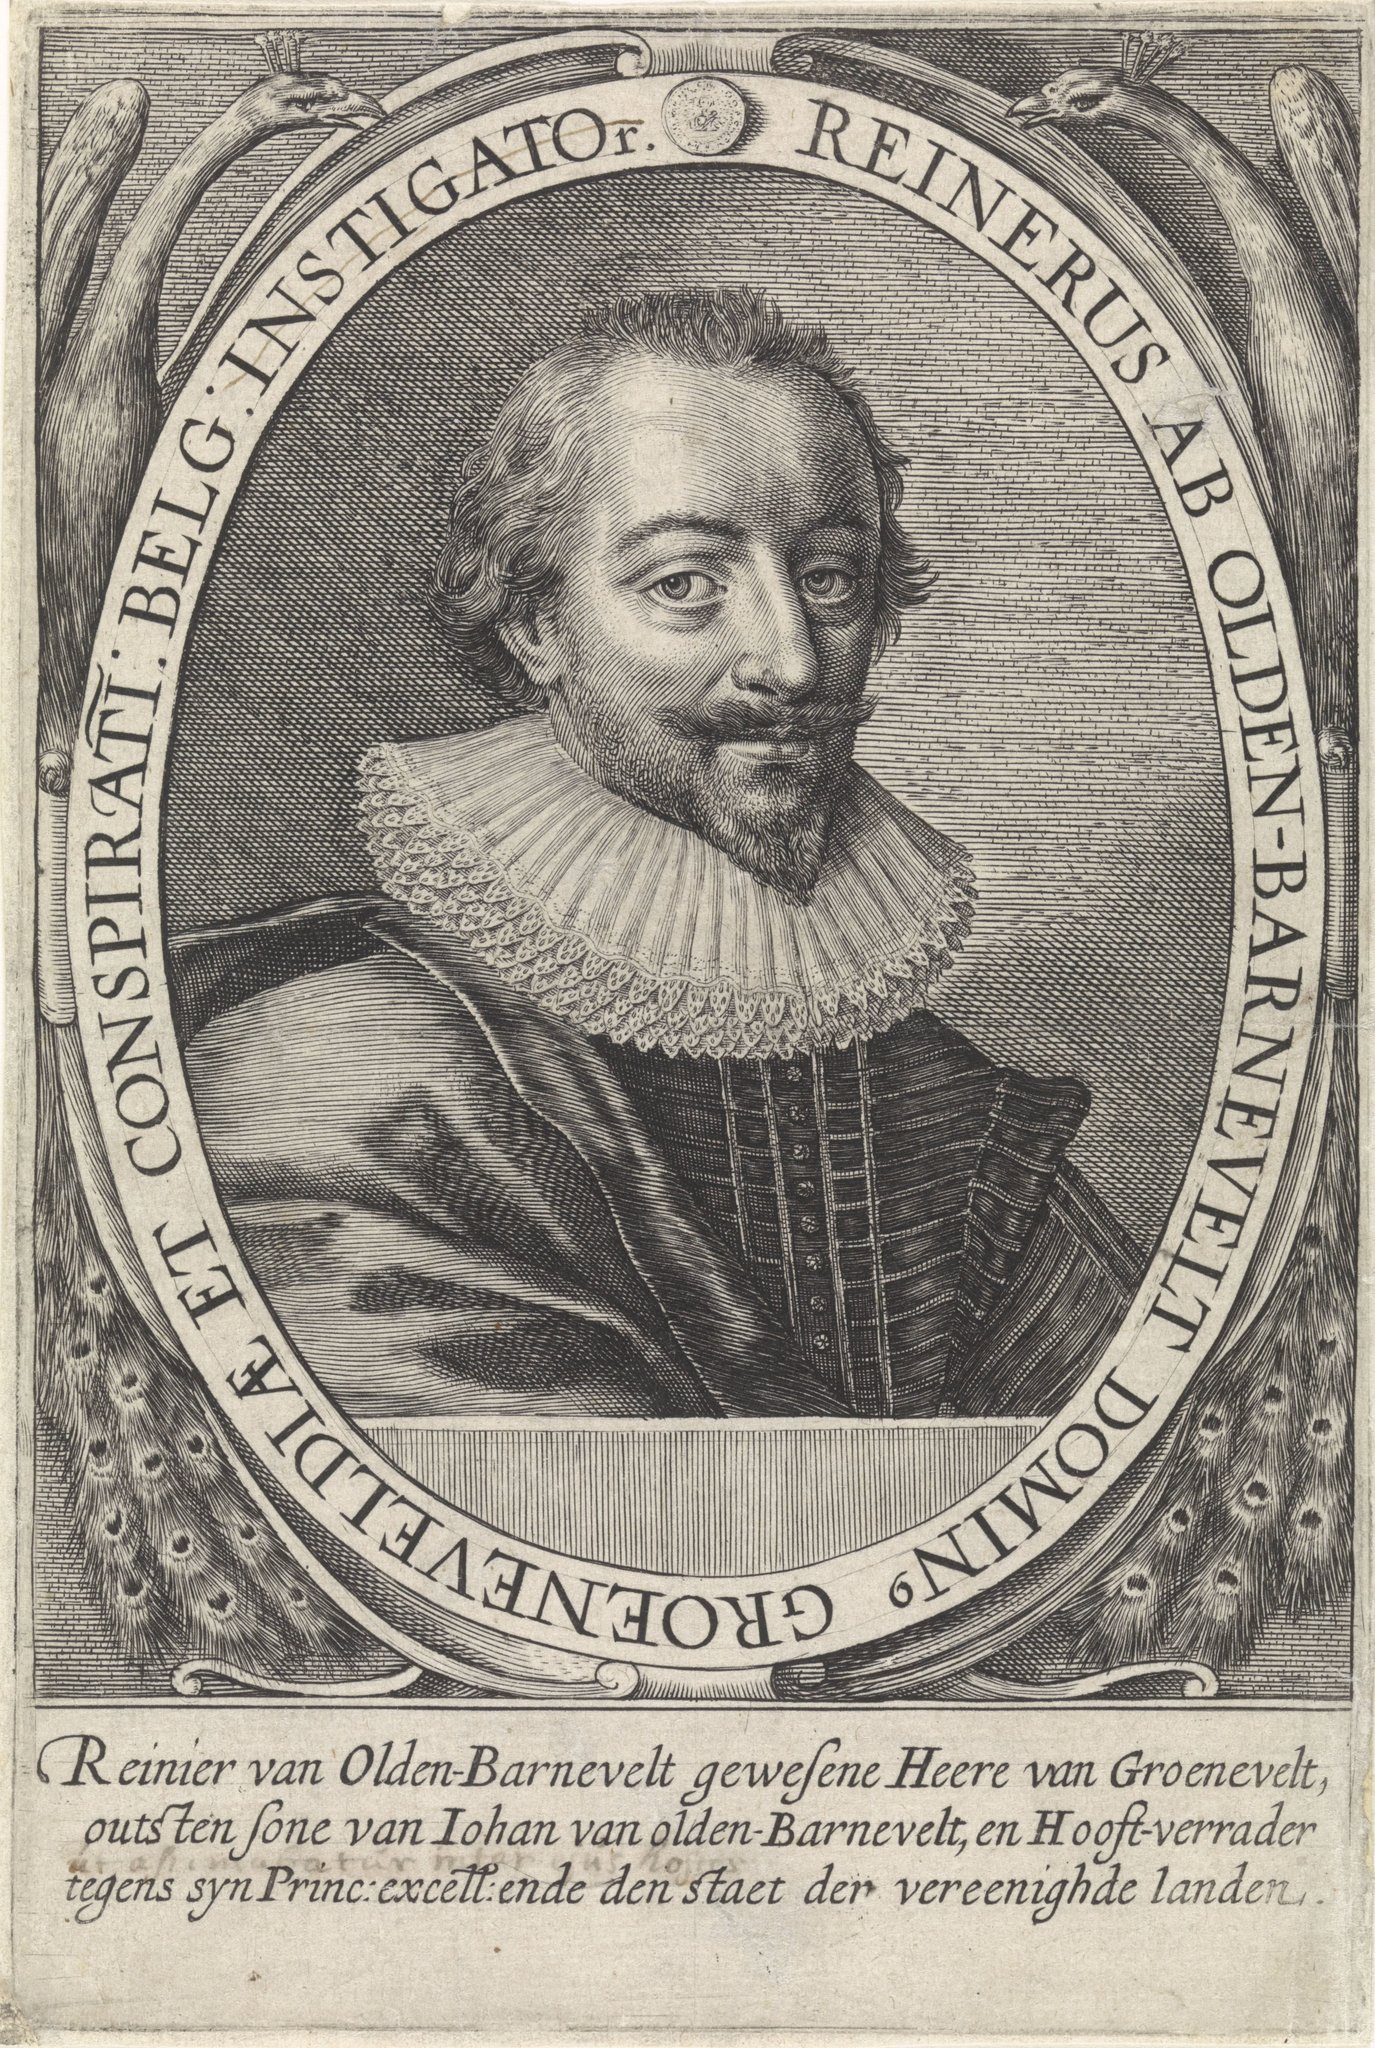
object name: print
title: Portret van Reinier van Oldenbarnevelt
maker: crispijn van de passe (i)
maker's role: draughtsman, print maker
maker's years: 1564-1637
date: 1574-1637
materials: paper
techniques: engraving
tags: ornamental birds: peacock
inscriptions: collector's mark: Lugt 240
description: Portret van Reinier van Oldenbarnevelt, heer van Groenveld. Hij werd ter dood veroordeeld en onthoofd vanwege zijn betrokkenheid bij het moordcomplot tegen prins Maurits. In het randschrift van de omlijsting de naam en functie van de geportretteerde in het Latijn. In de marge een drieregelig onderschrift in het Nederlands. Pendant van een portret van Henricus Slatius.